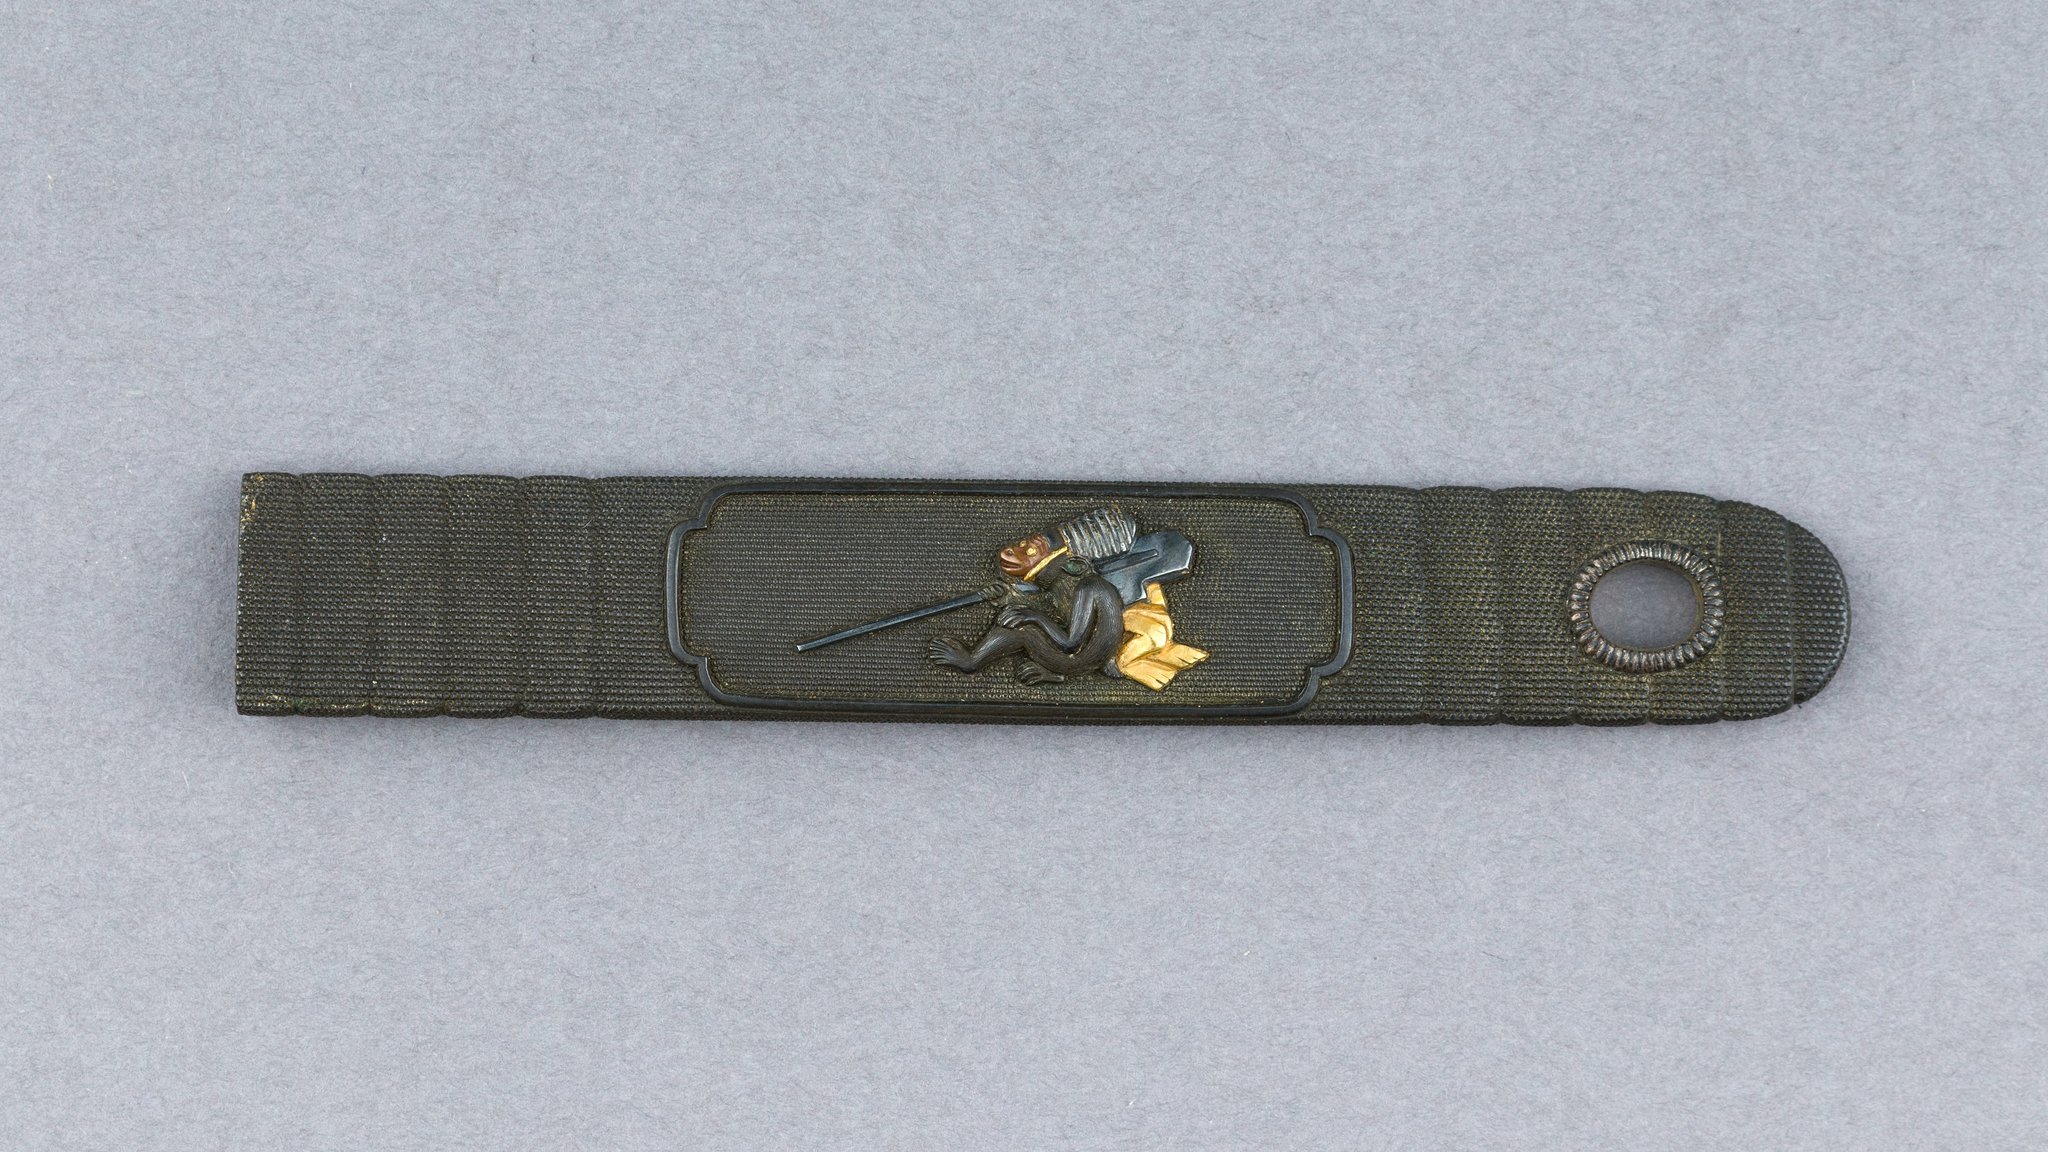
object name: knife handle kozuka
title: Knife Handle (Kozuka)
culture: japanese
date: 1615-1868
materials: copper, gold alloy, gold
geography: japan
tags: monkeys